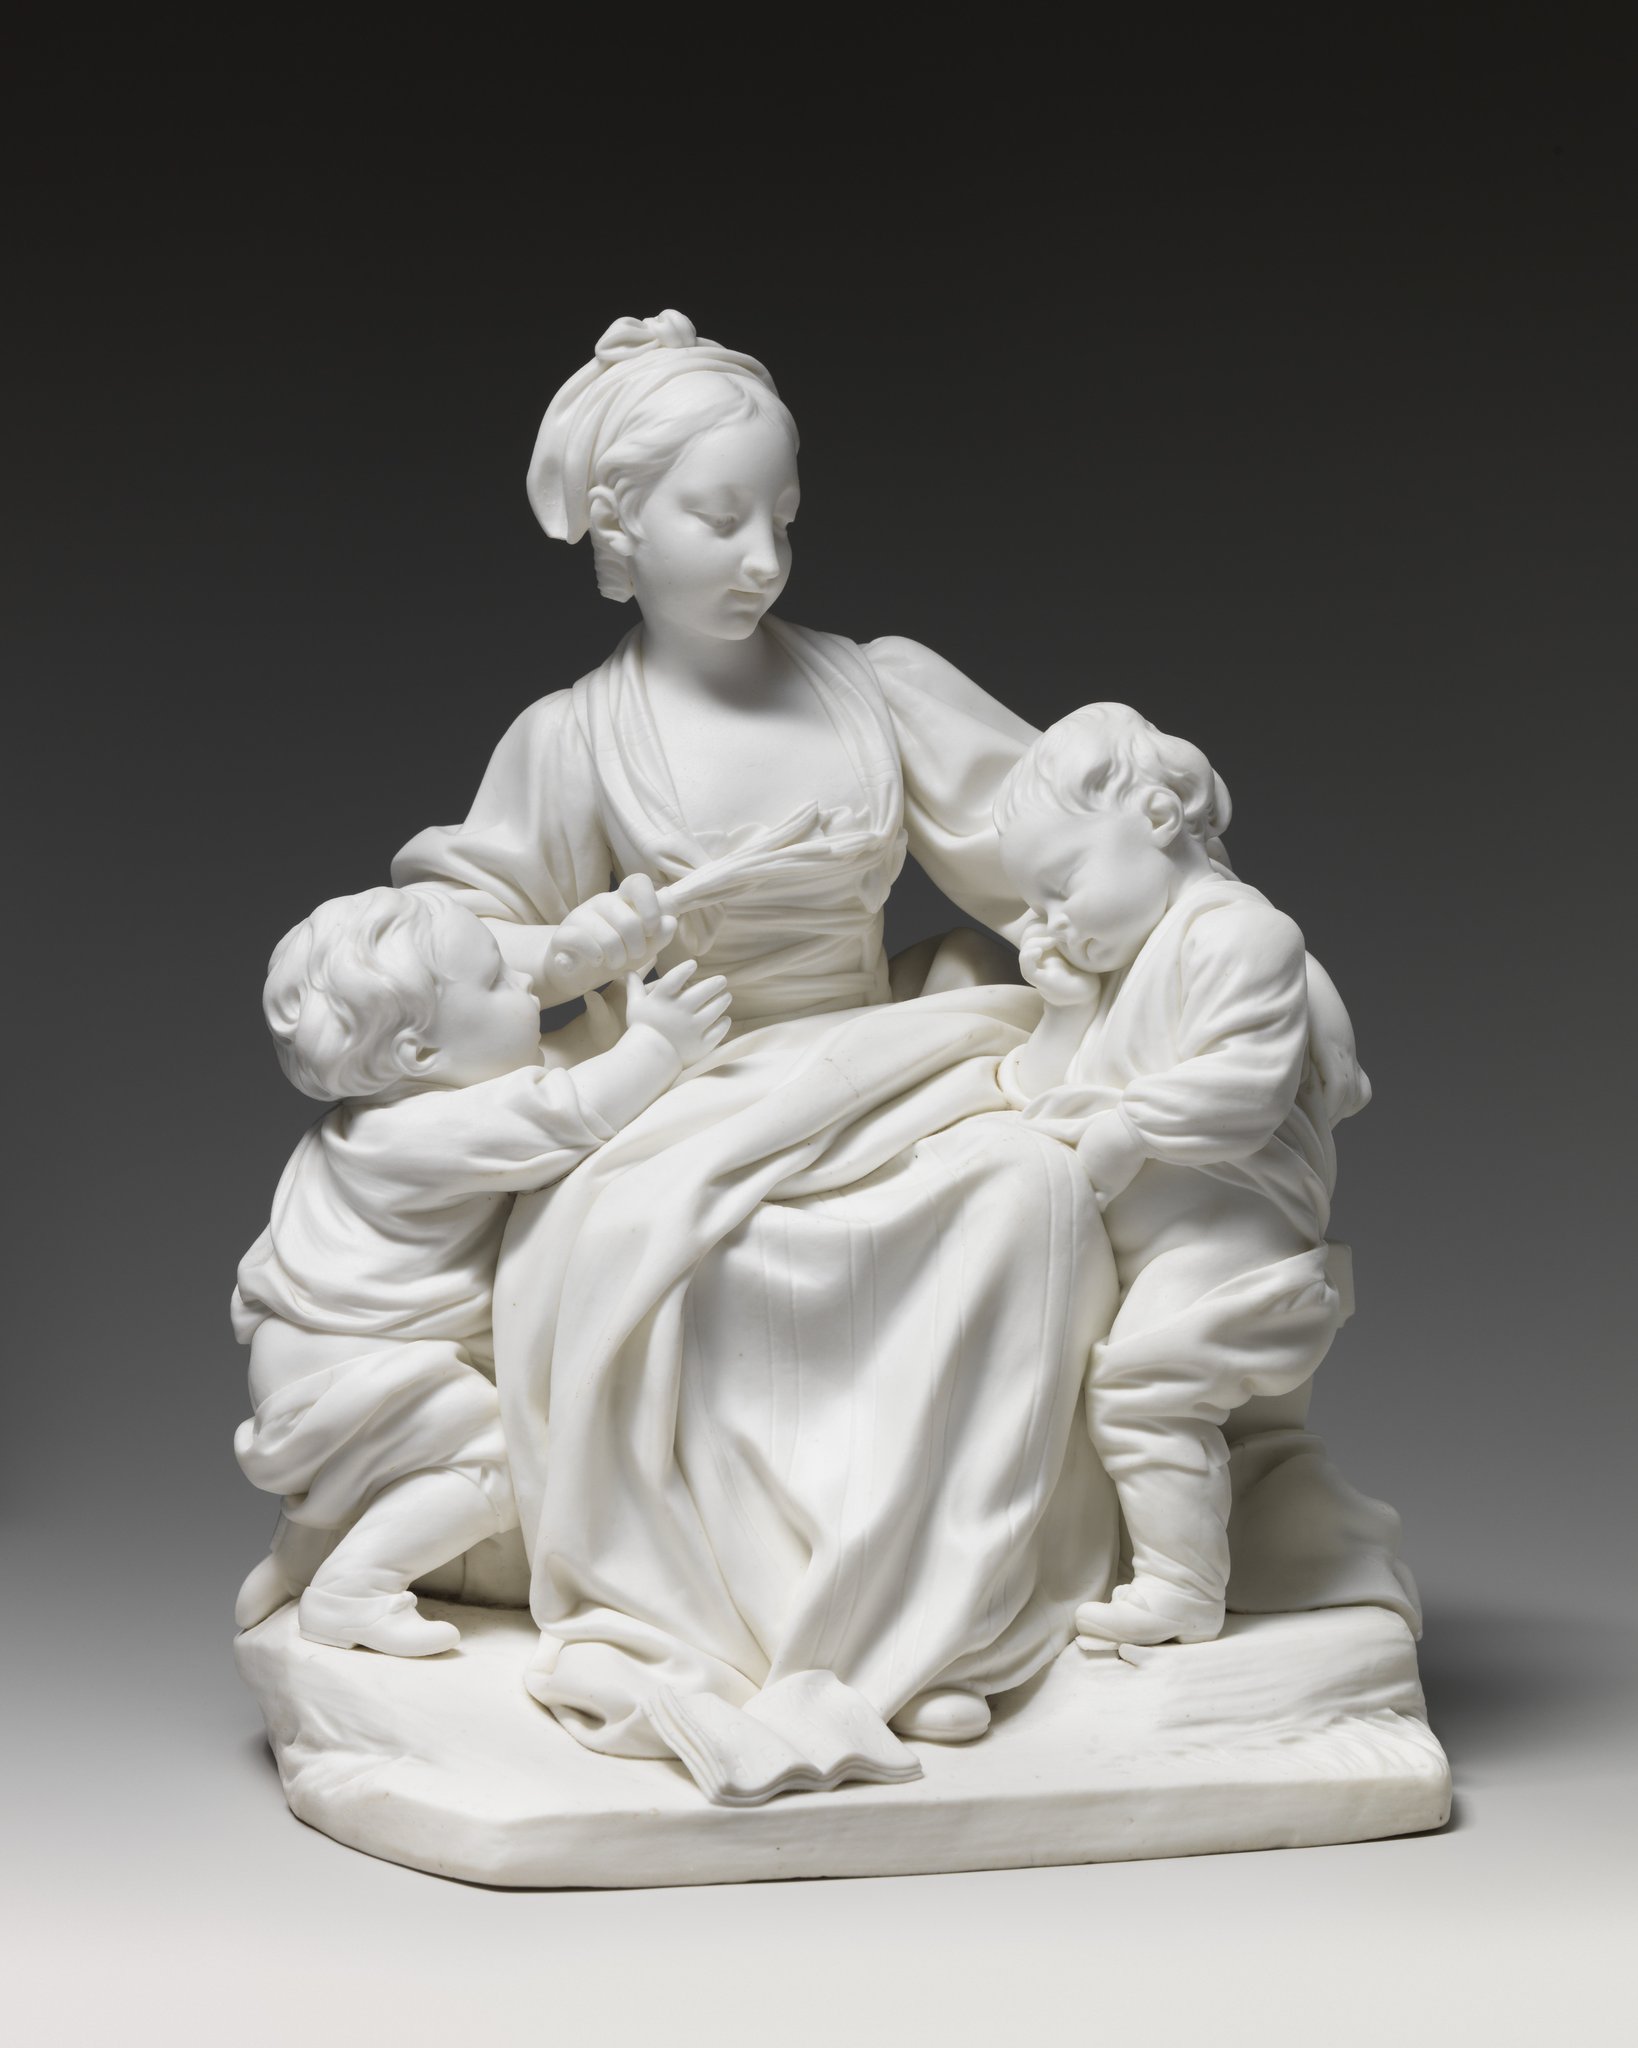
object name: group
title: The Schoolmistress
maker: sèvres manufactory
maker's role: manufactory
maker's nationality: french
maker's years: 1740-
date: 1762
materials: biscuit, paste, porcelain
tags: children,women